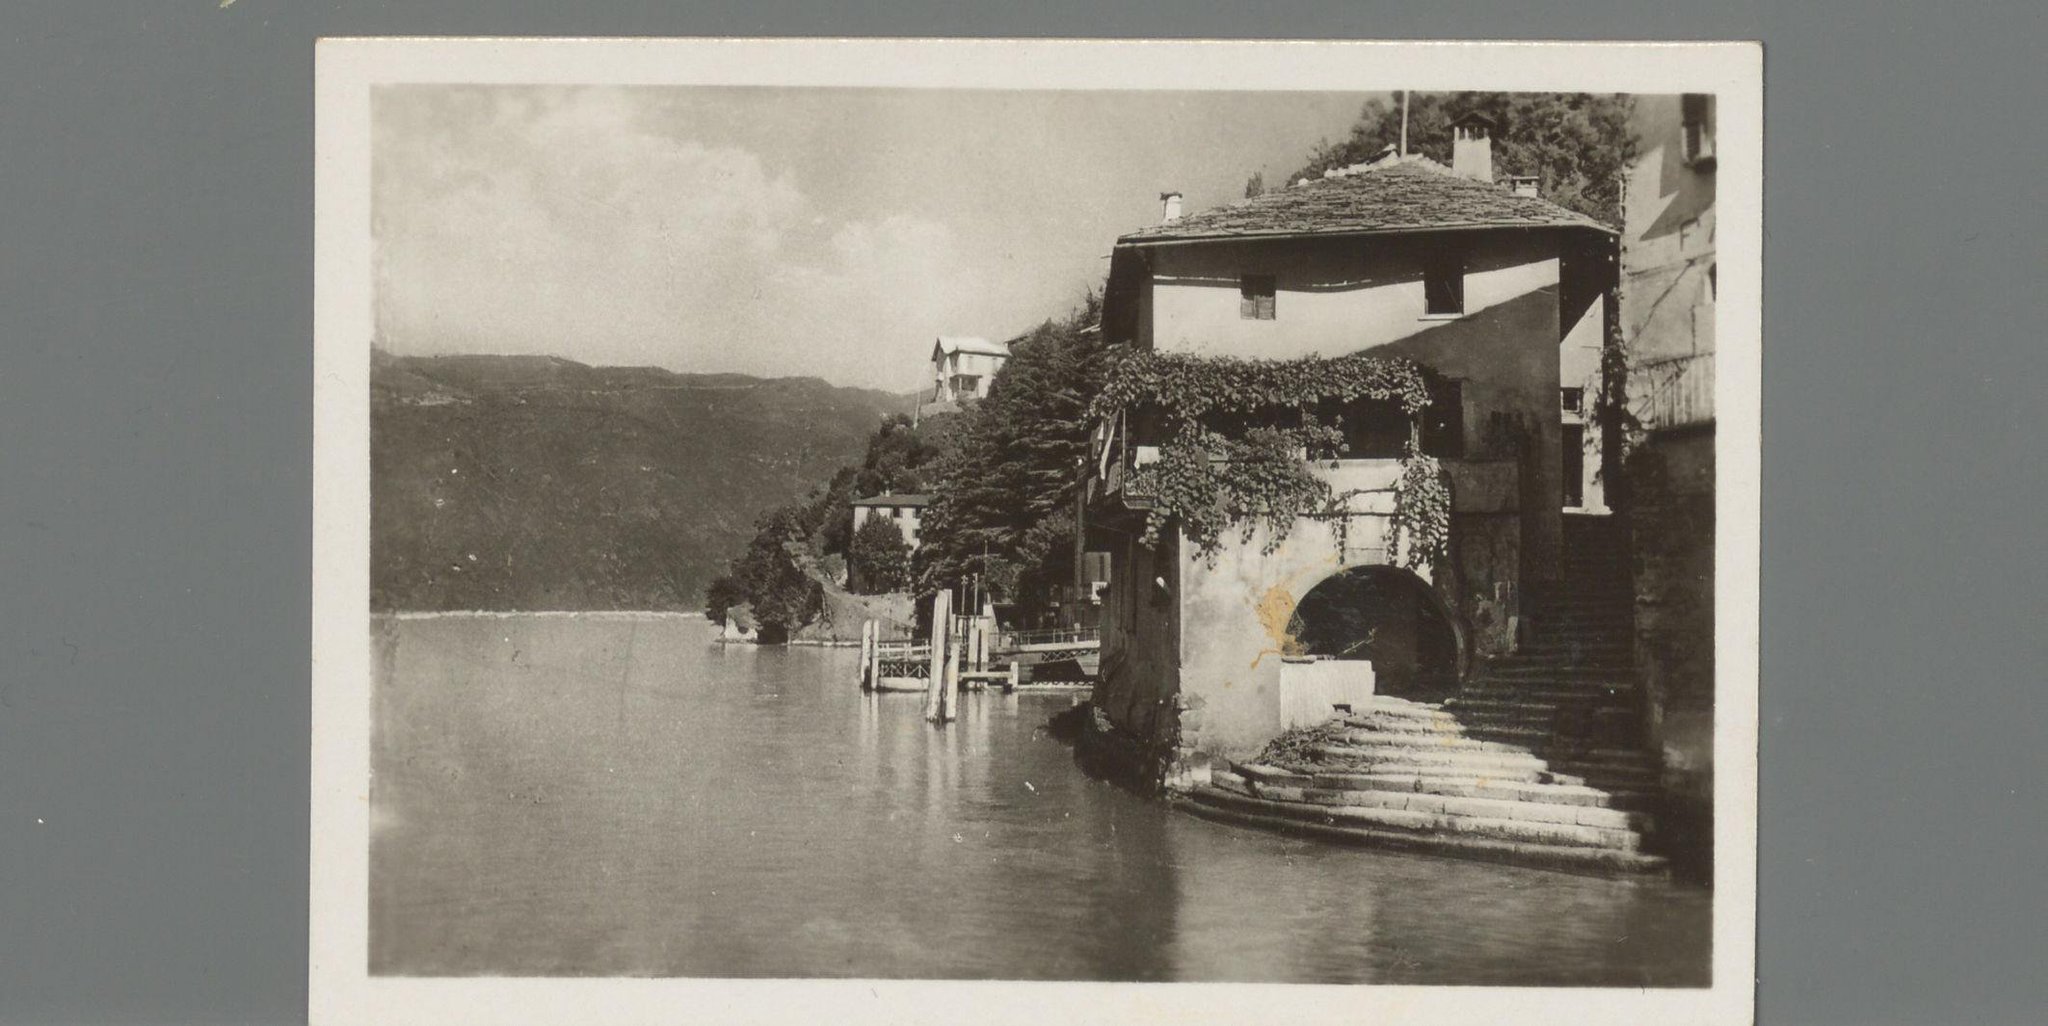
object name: photograph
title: Lago di Como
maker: Anonymous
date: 1910-1930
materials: paper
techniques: gelatin silver print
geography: nesso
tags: prospect of village, silhouette of village, lake